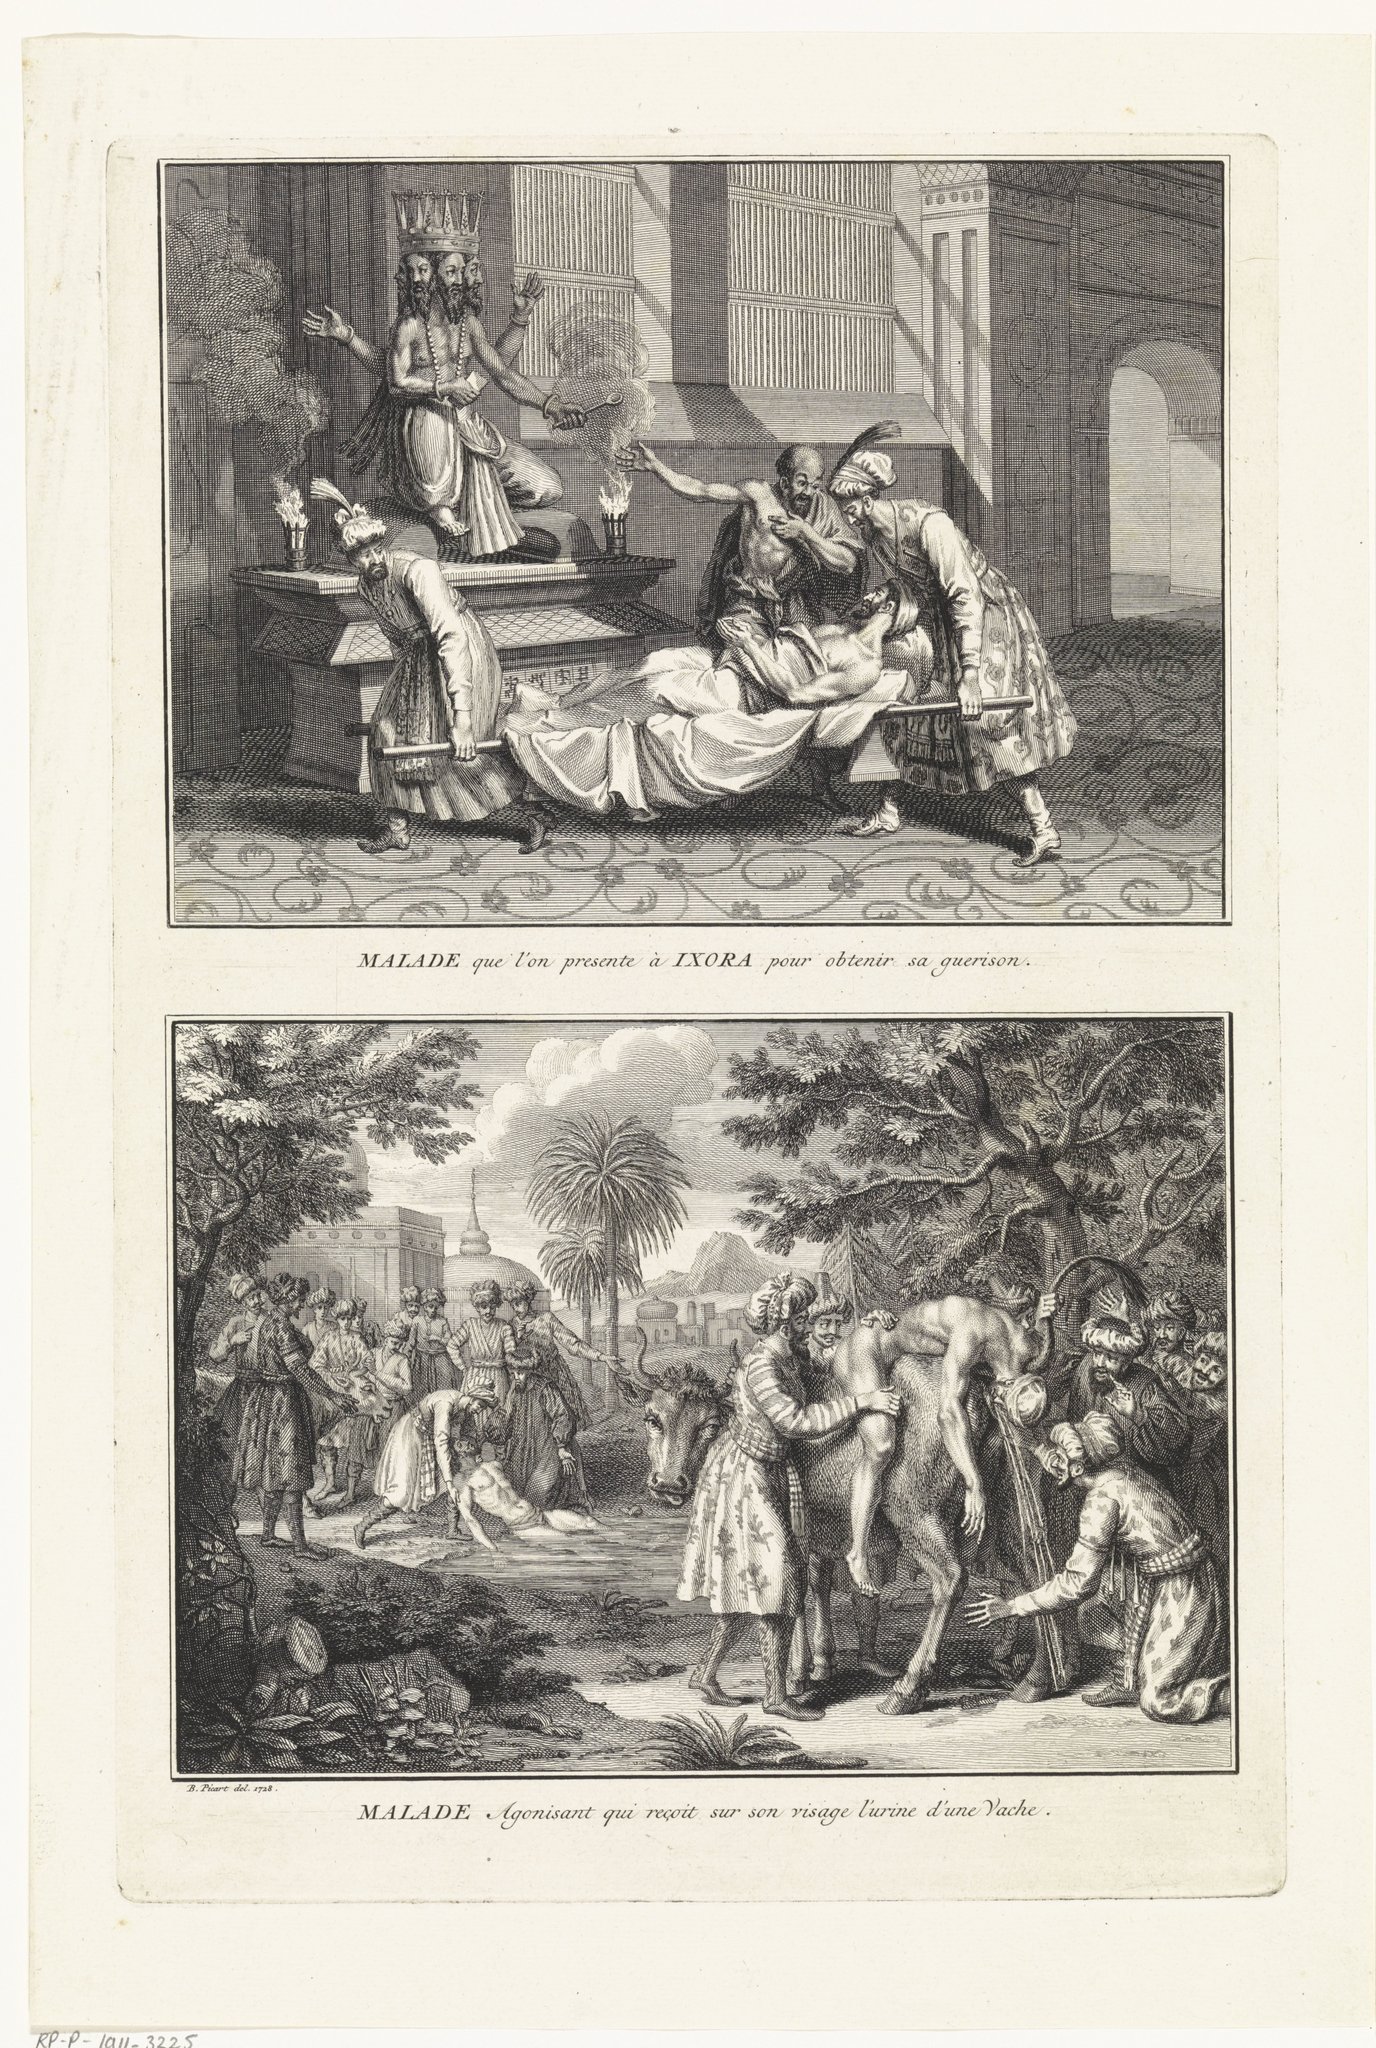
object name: print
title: Zieke voor de god Ixora gebracht / Zieke met zijn gezicht in de urine van een koe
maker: bernard picart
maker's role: draughtsman, print maker, publisher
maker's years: 1673-1733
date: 1728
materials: paper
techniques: engraving, etching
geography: amsterdam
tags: magic healings, ritual practices ~ hinduism, buddhism, jainism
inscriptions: collector's mark: Lugt 2228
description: Blad met twee voorstellingen van religieuze gebruiken in India. Boven: Een zieke wordt op een draagbaar voor het beeld van de Indiase god Ixora gebracht. Onder: Een zieke wordt met zijn gezicht achter een koe gehouden, zodat de koe in zijn gezicht urineert. Op de achtergrond baadt men een lijk in de Ganges.